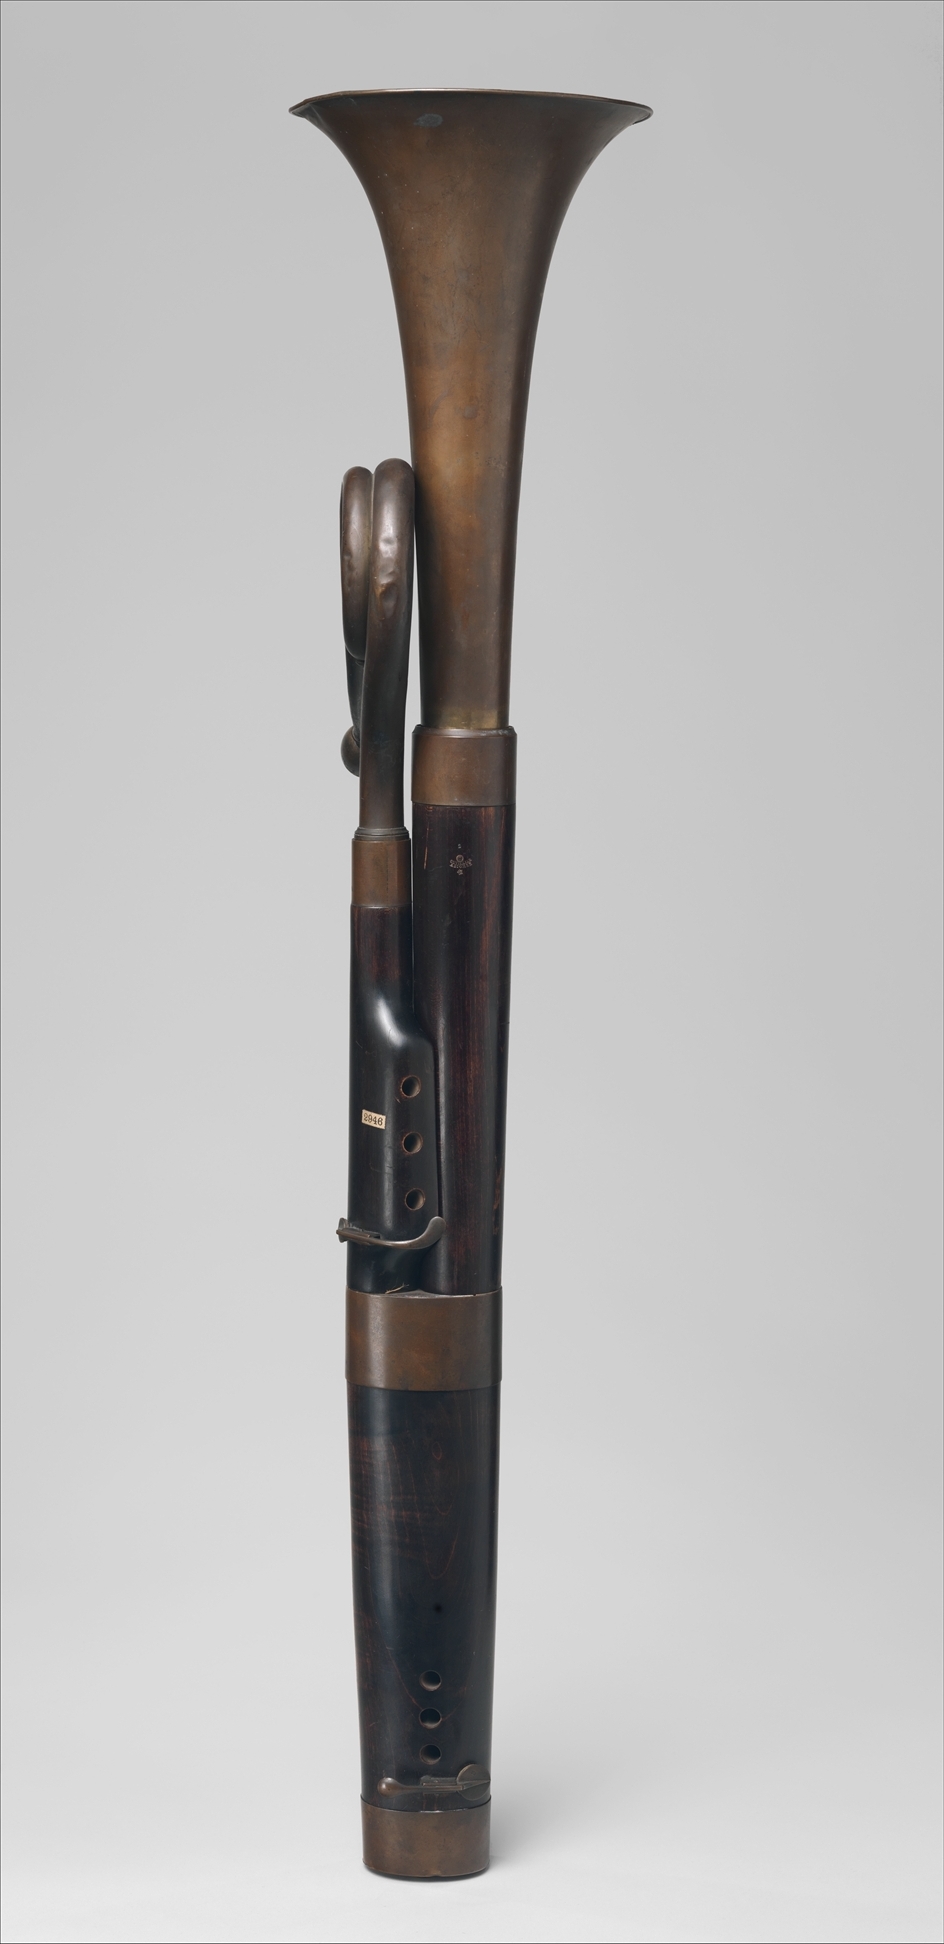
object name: russian bassoon in c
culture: french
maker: cuvillier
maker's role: maker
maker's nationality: french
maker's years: 1792-1825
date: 1800-1825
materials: brass, wood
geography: france